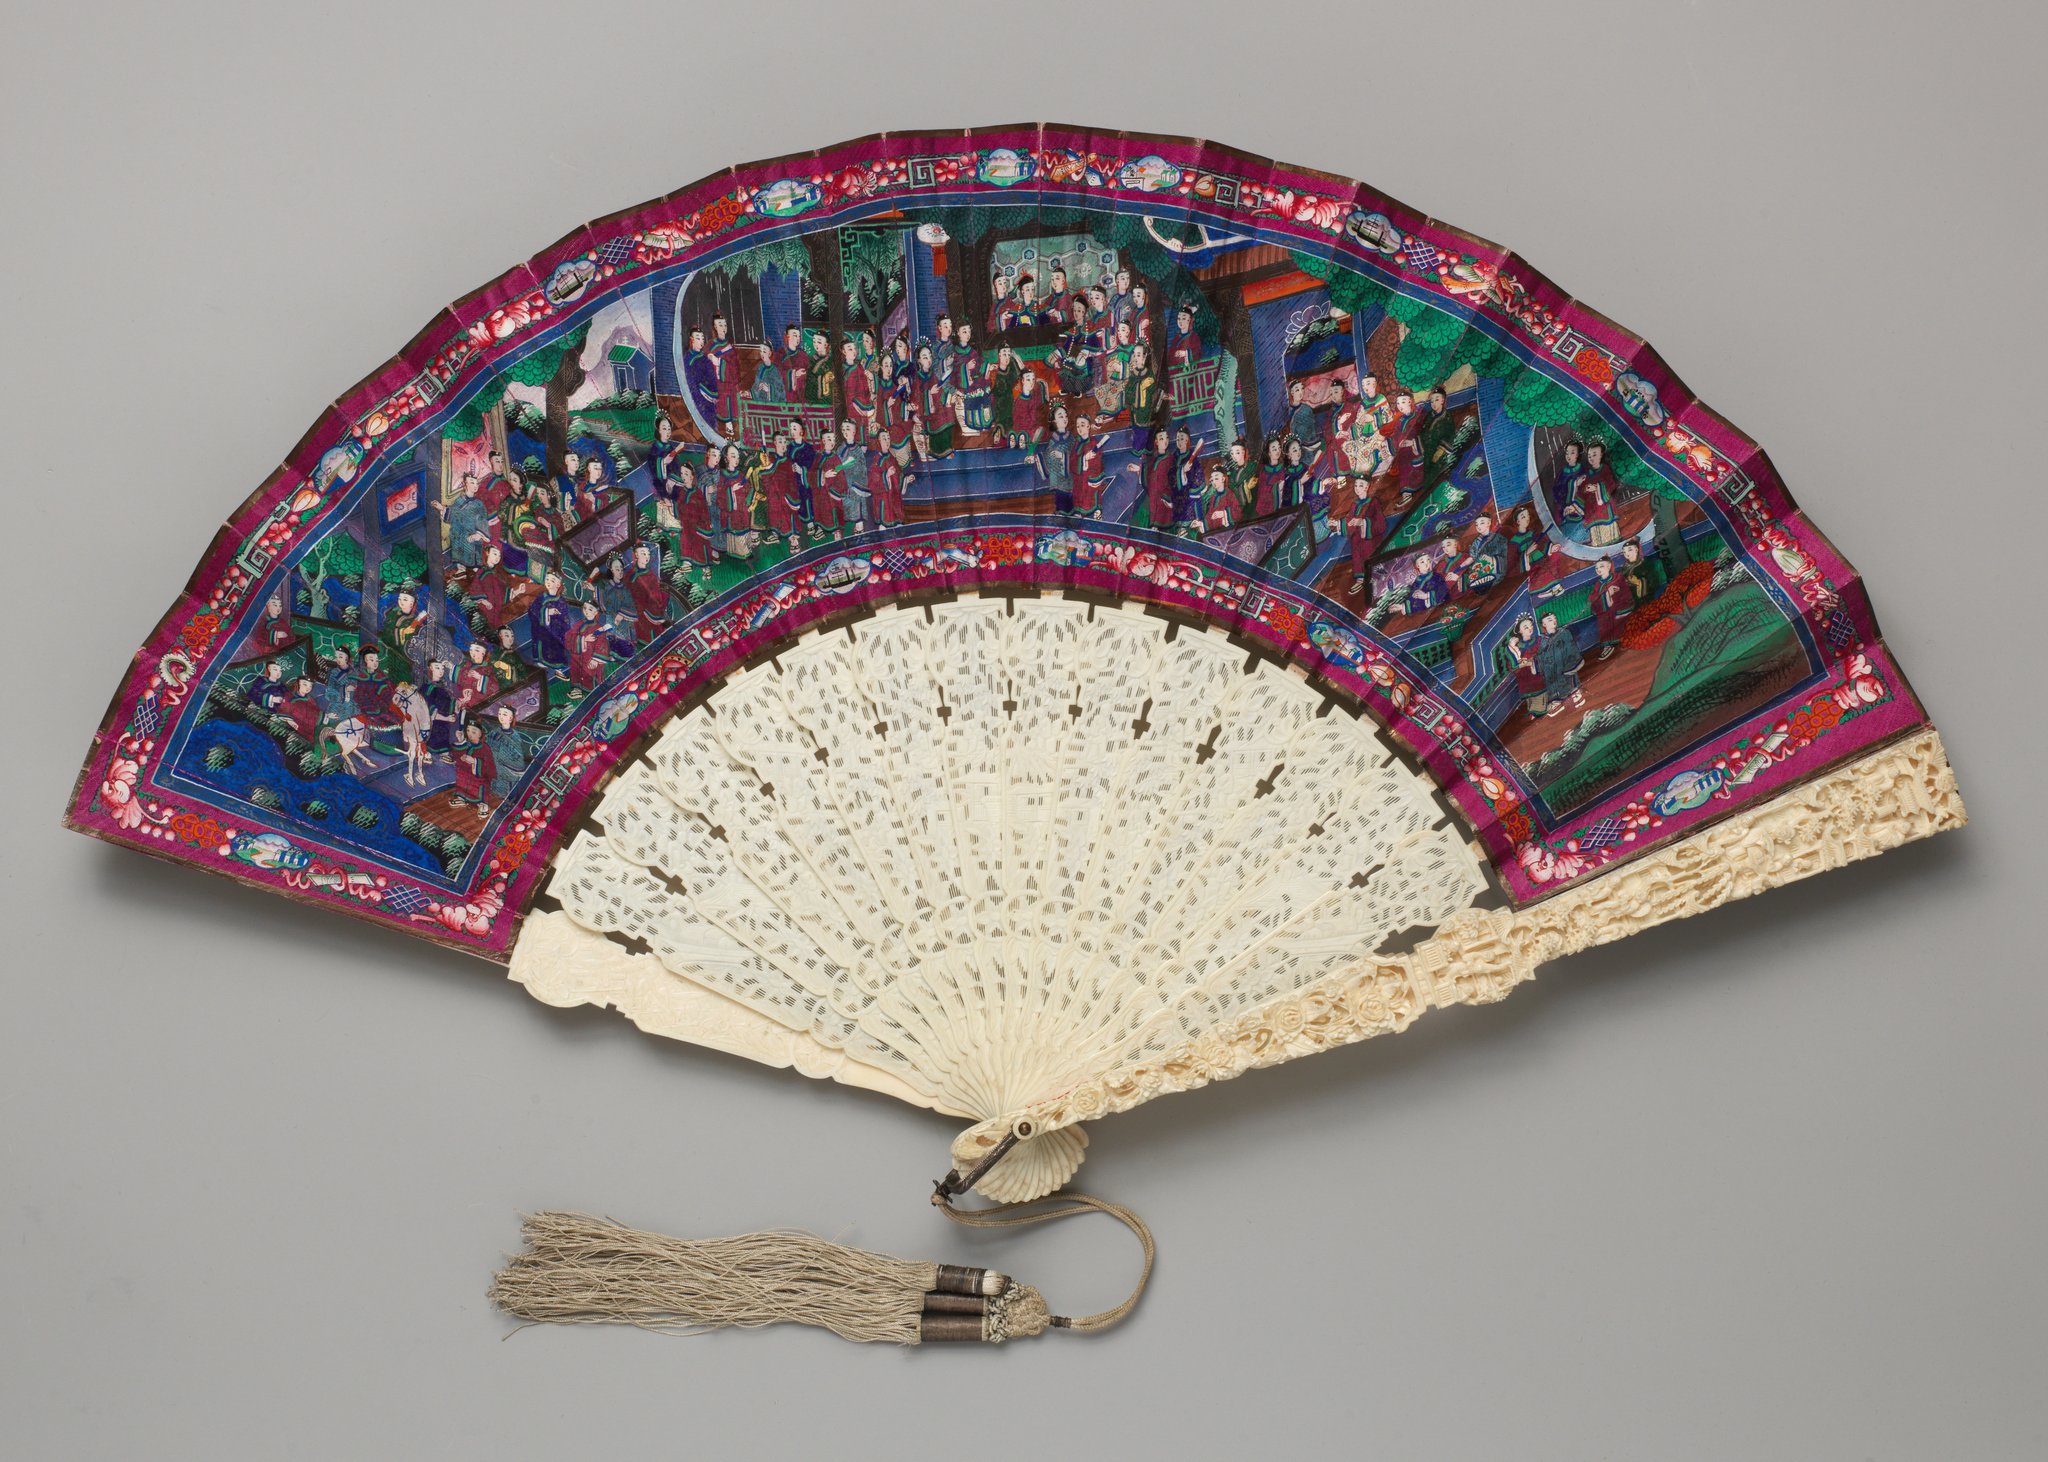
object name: fan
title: Folding Fan with Scene of Figures in a Courtyard Garden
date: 1801-1900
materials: ivory, paper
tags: men,women